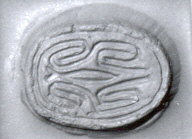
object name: stamp seal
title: Scarab seal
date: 1700-1560 BCE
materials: faience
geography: levant or syria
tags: scarabs